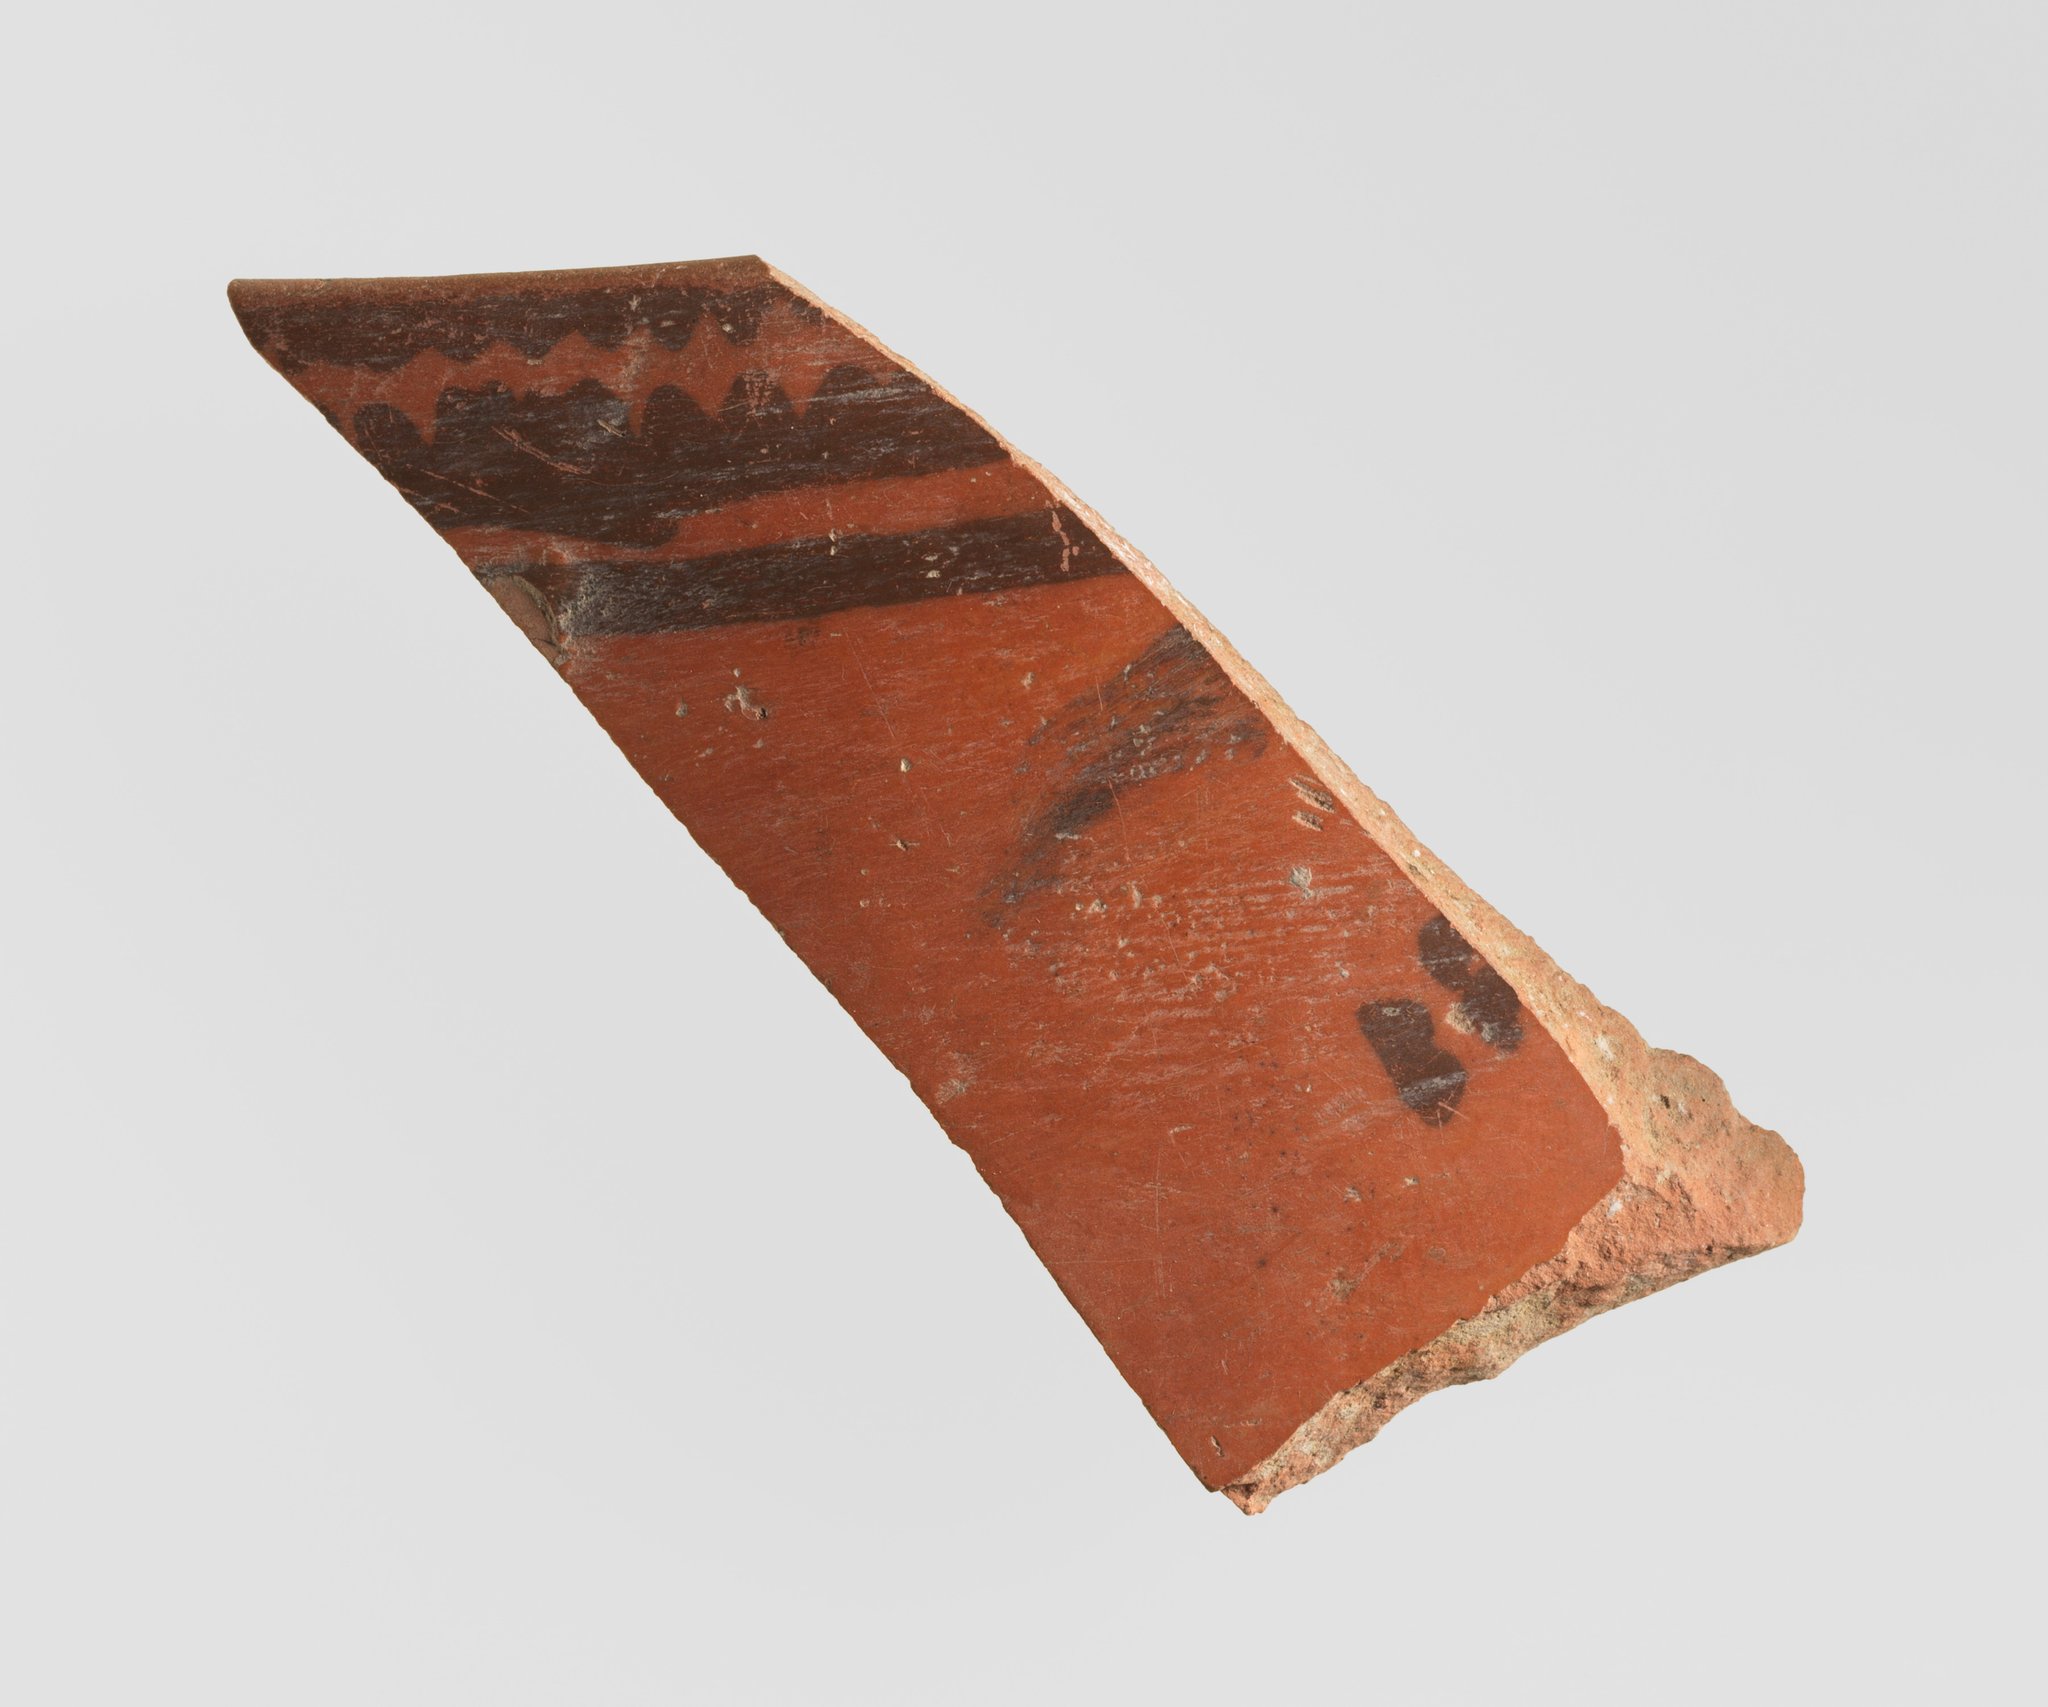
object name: sherd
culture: iranian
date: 4000-3500 BCE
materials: ceramic, glaze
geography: iran